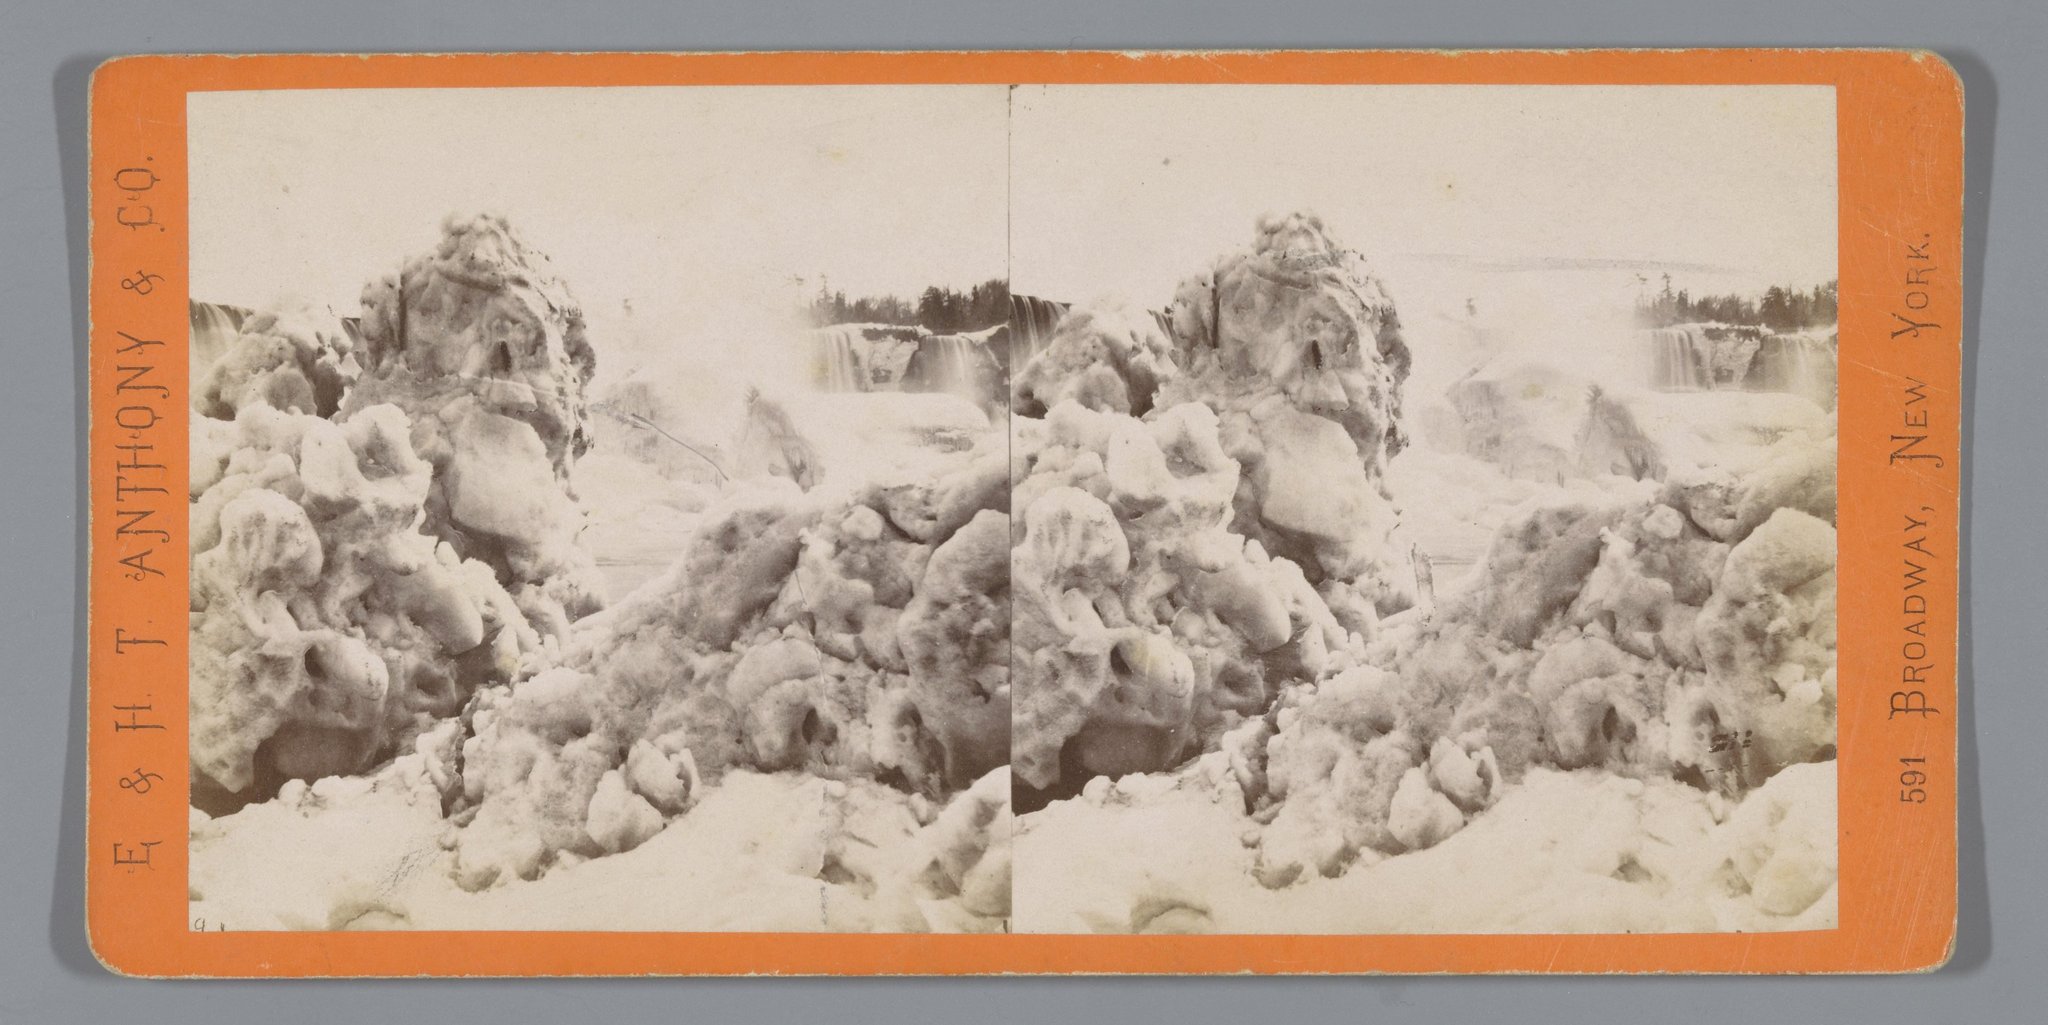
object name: stereograph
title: Ice Jam below the American Fall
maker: Anonymous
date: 1871-1888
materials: cardboard, paper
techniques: albumen print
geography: new york city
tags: iceberg, ice ~ freezing weather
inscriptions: address: ‘Emporium of American and Foreign Stereoscopic Views, Chromos and Albums, 591 Broadway, opposite Metropolitan Hotel, New York.’, number: ‘No. 91, 92.’